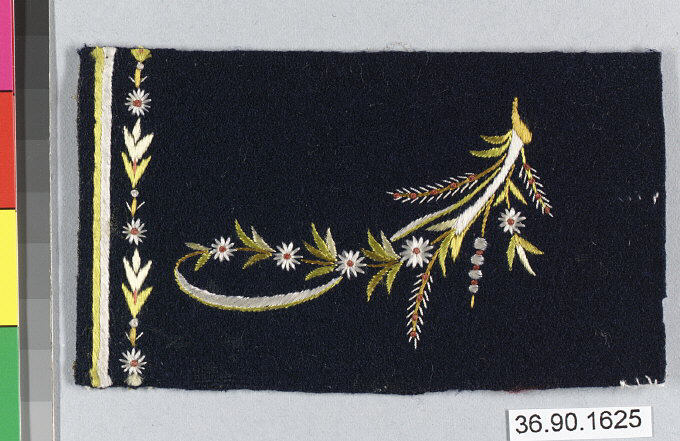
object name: sample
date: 1801-1833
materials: felt, silk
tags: flowers